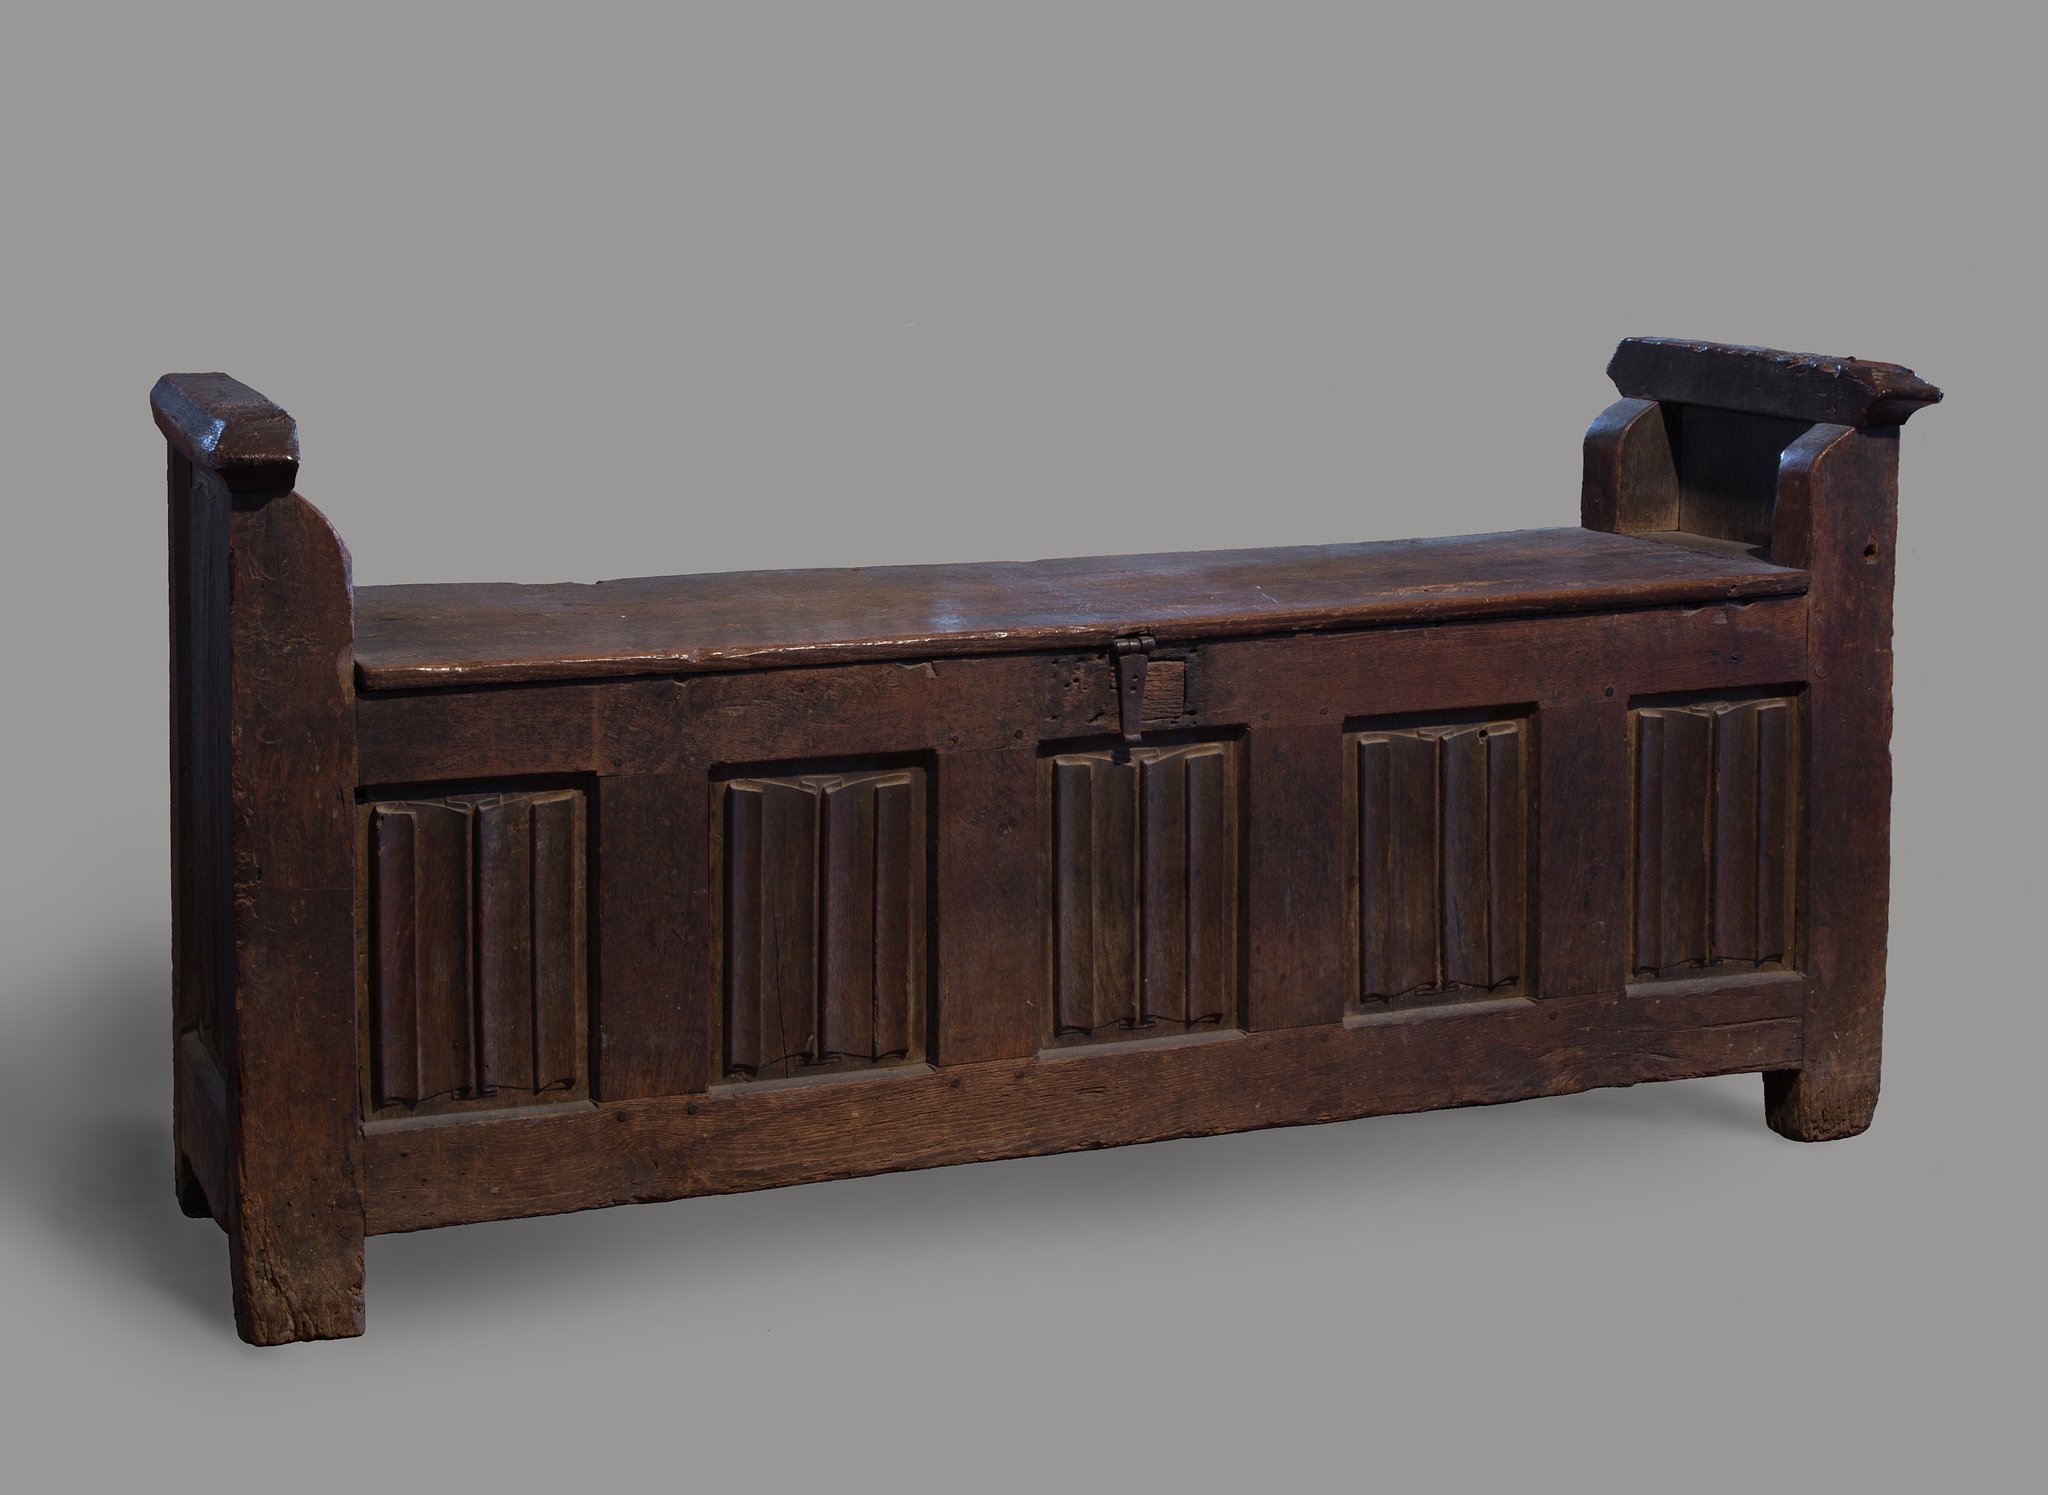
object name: bench or chest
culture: french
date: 1401-1500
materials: wood